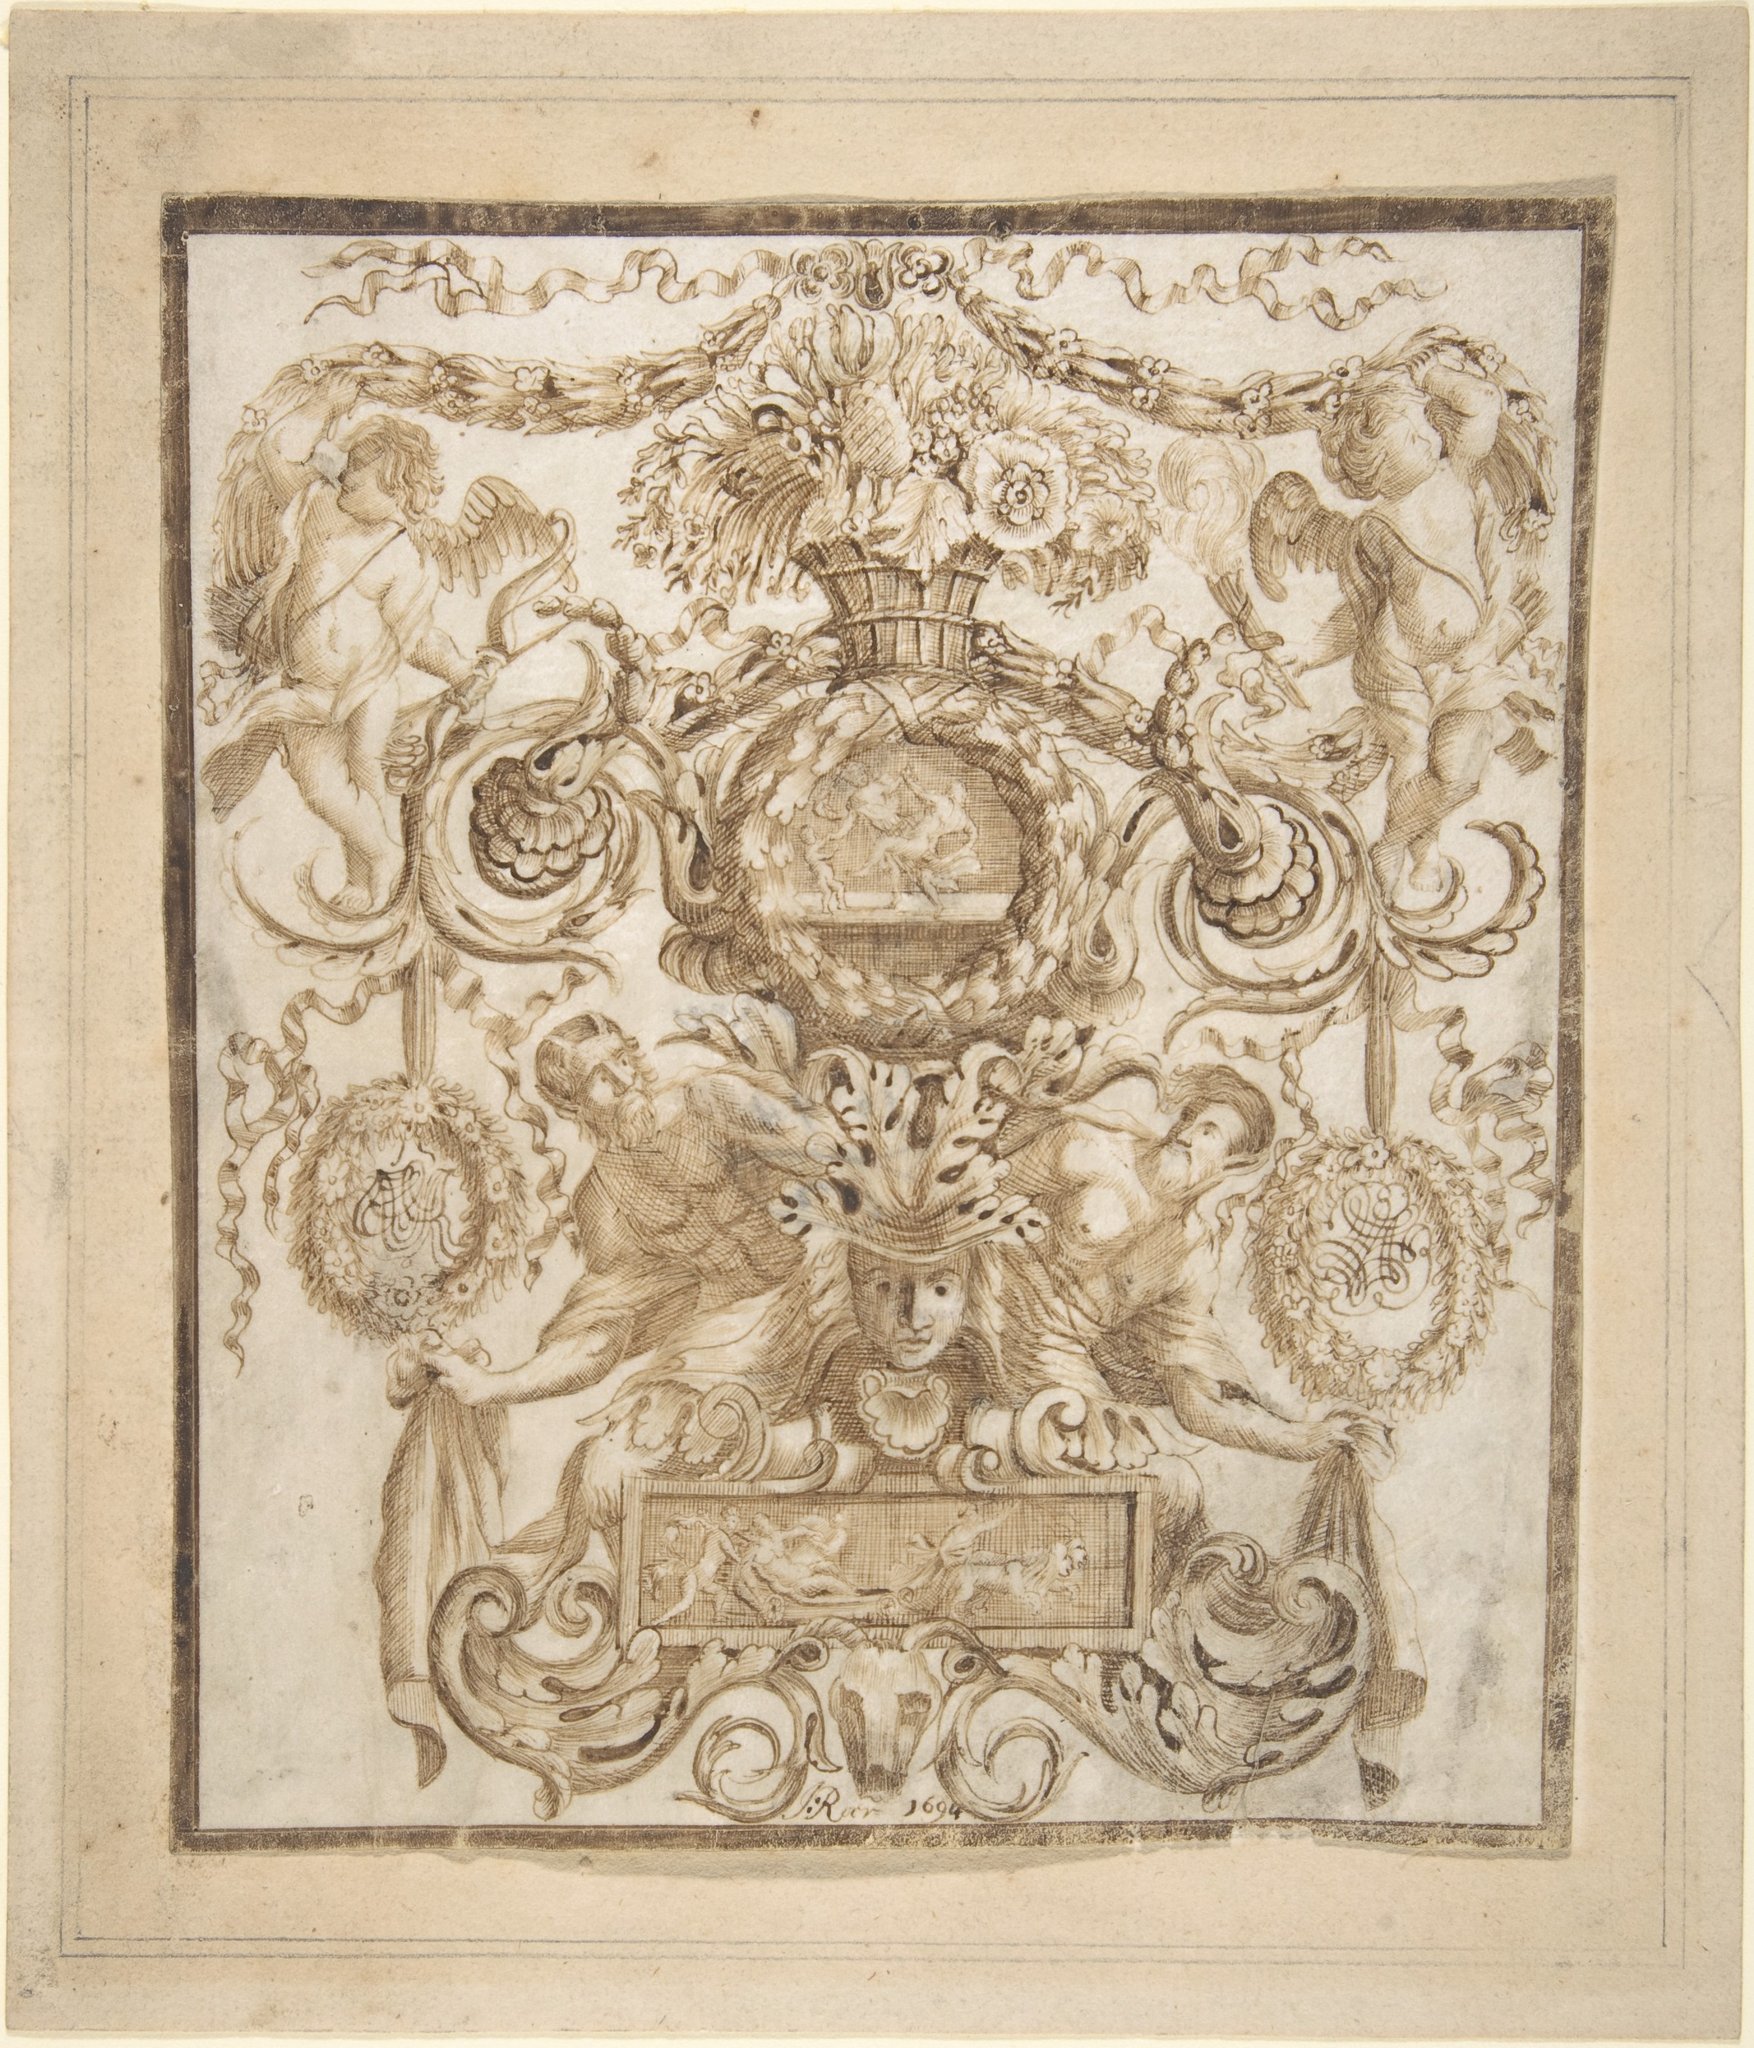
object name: drawing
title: Ornamental Design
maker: jacob roer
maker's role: artist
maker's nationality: dutch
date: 1694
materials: ink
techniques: brush, pen, wash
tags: garlands,ornament,men,cupid,flowers